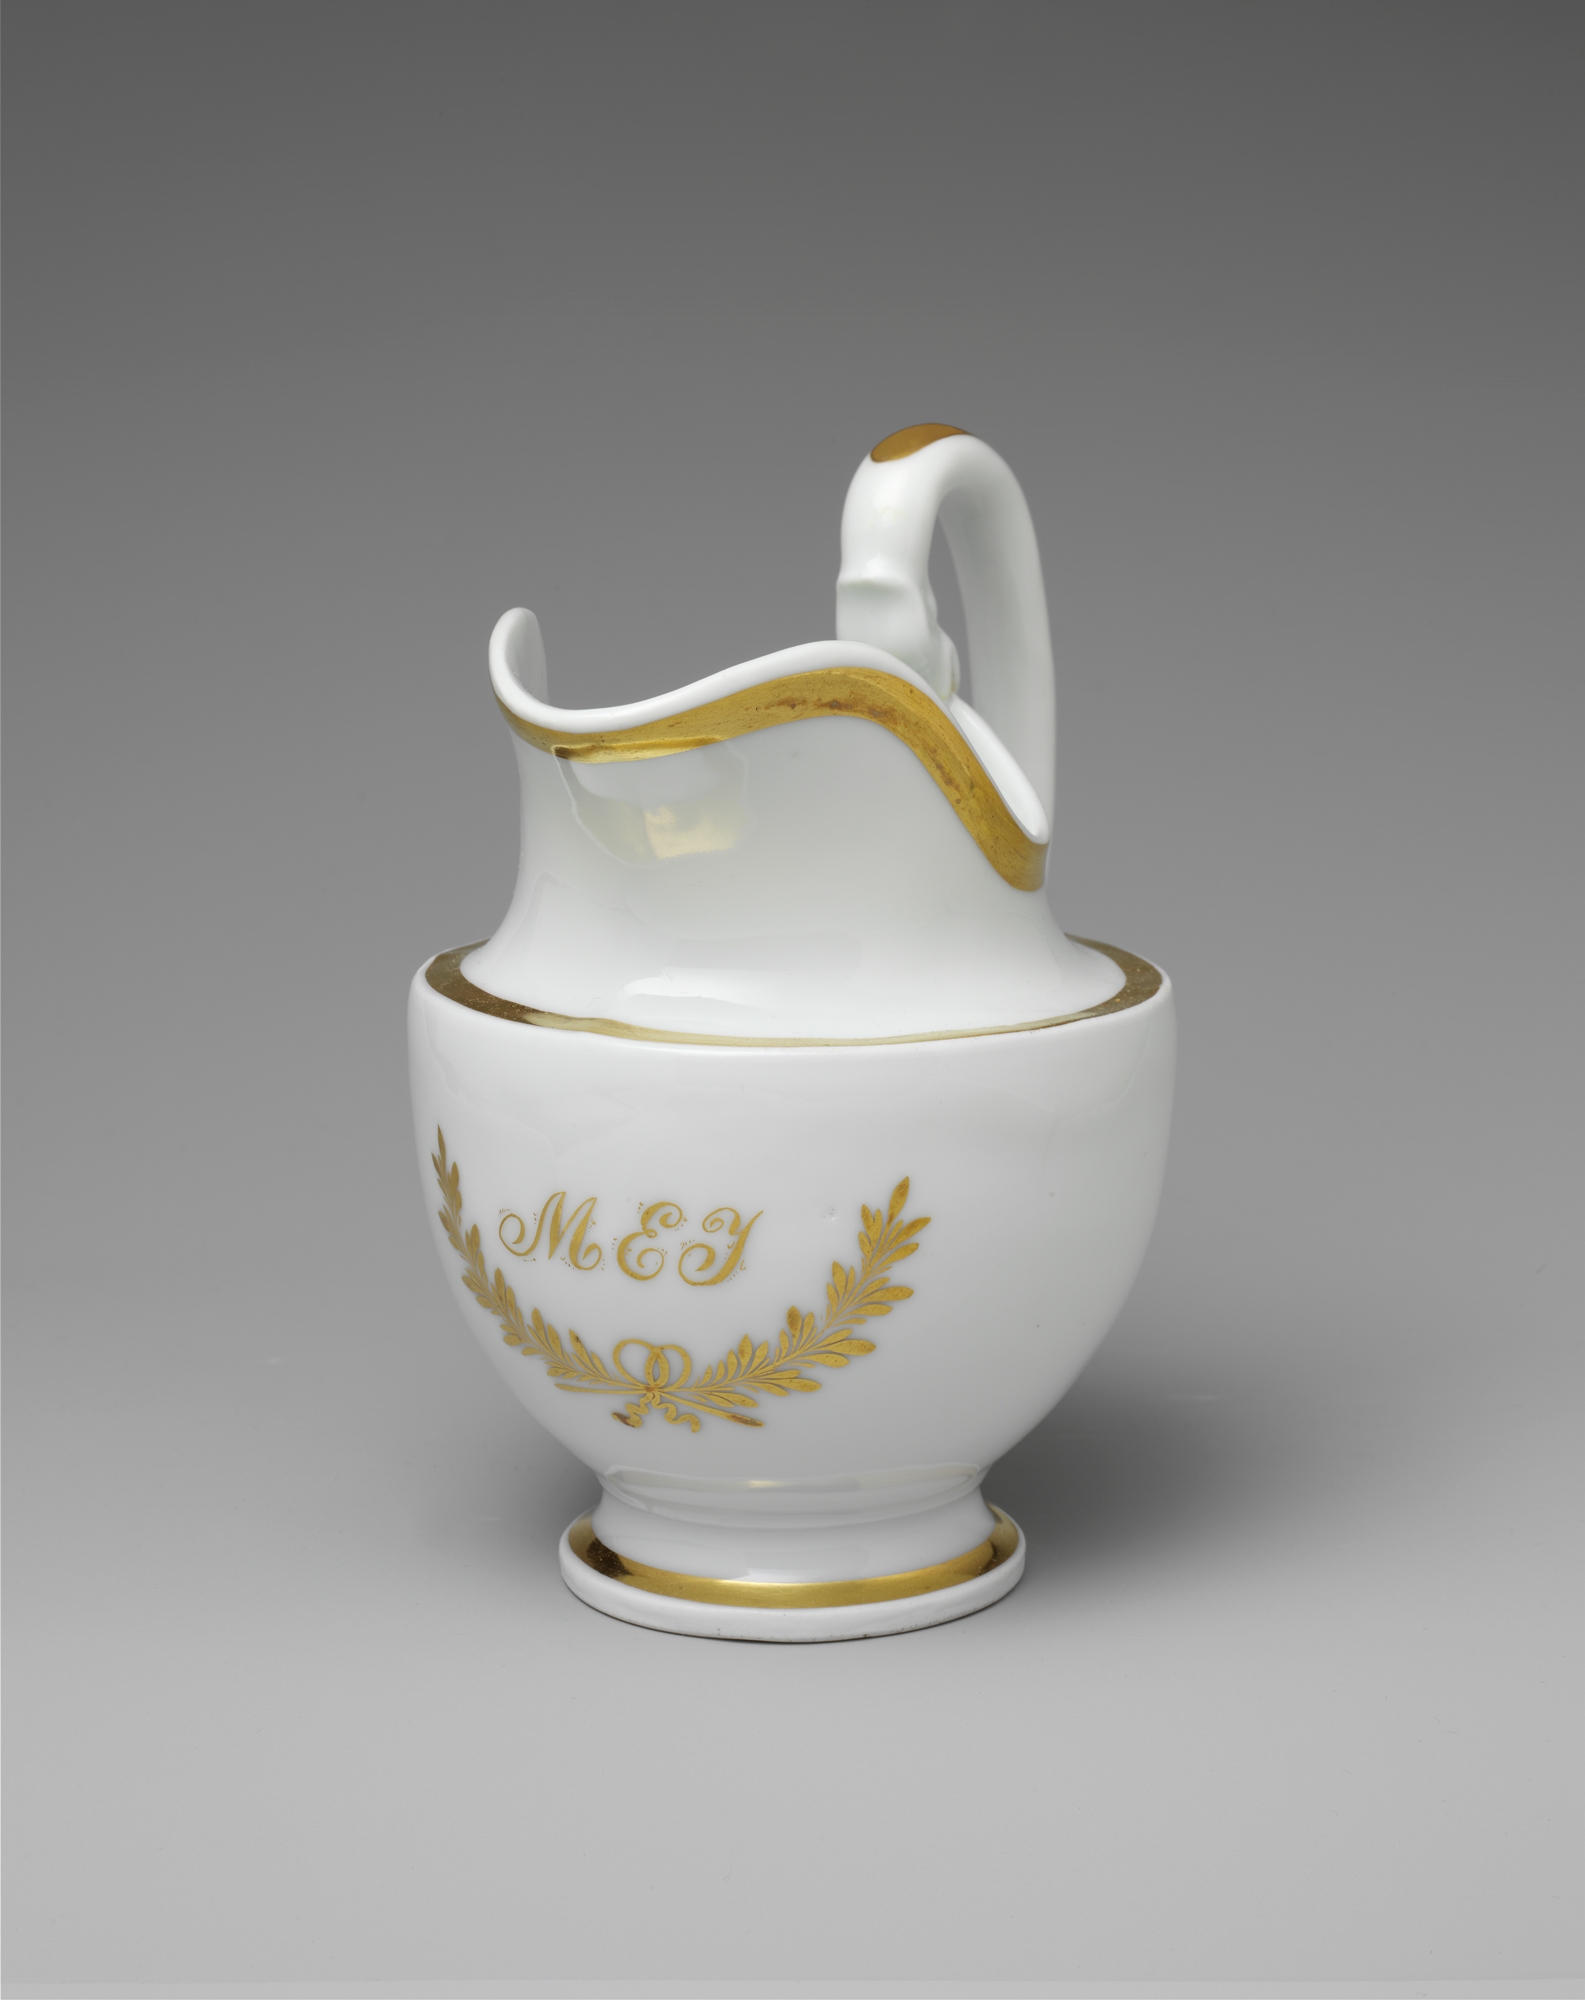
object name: cream pot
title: Creamer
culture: american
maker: tucker factory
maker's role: maker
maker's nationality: american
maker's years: 1826-1838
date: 1838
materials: porcelain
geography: united states